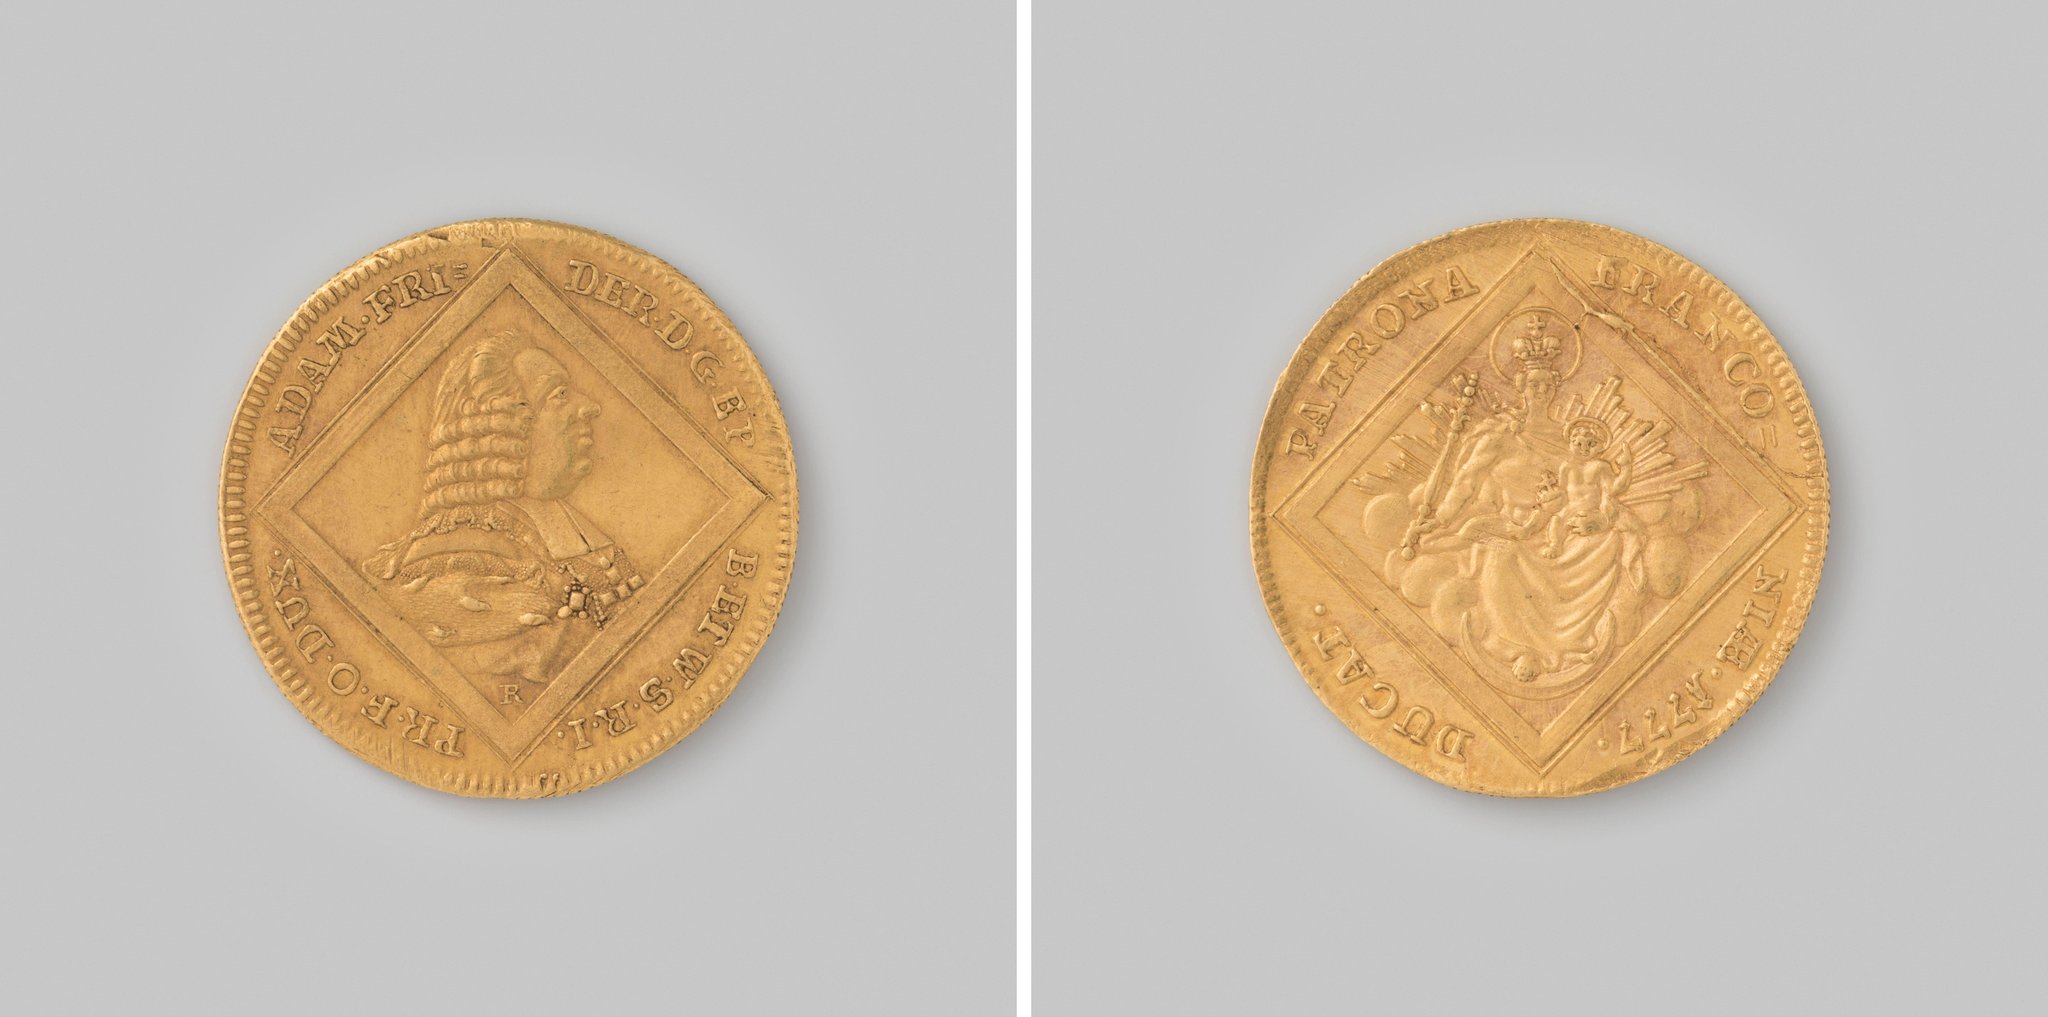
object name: goudgulden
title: Bisdom Bamberg, Adam Friedrich van Seinsheim, goudgulden, 1777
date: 1777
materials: gold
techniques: striking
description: Gouden munt. Voorzijde: in ruit borstbeeld van de bisschop naar rechts. Keerzijde: in ruit de madonna met het kind. Jaartal in omschrift. Kabelrand.